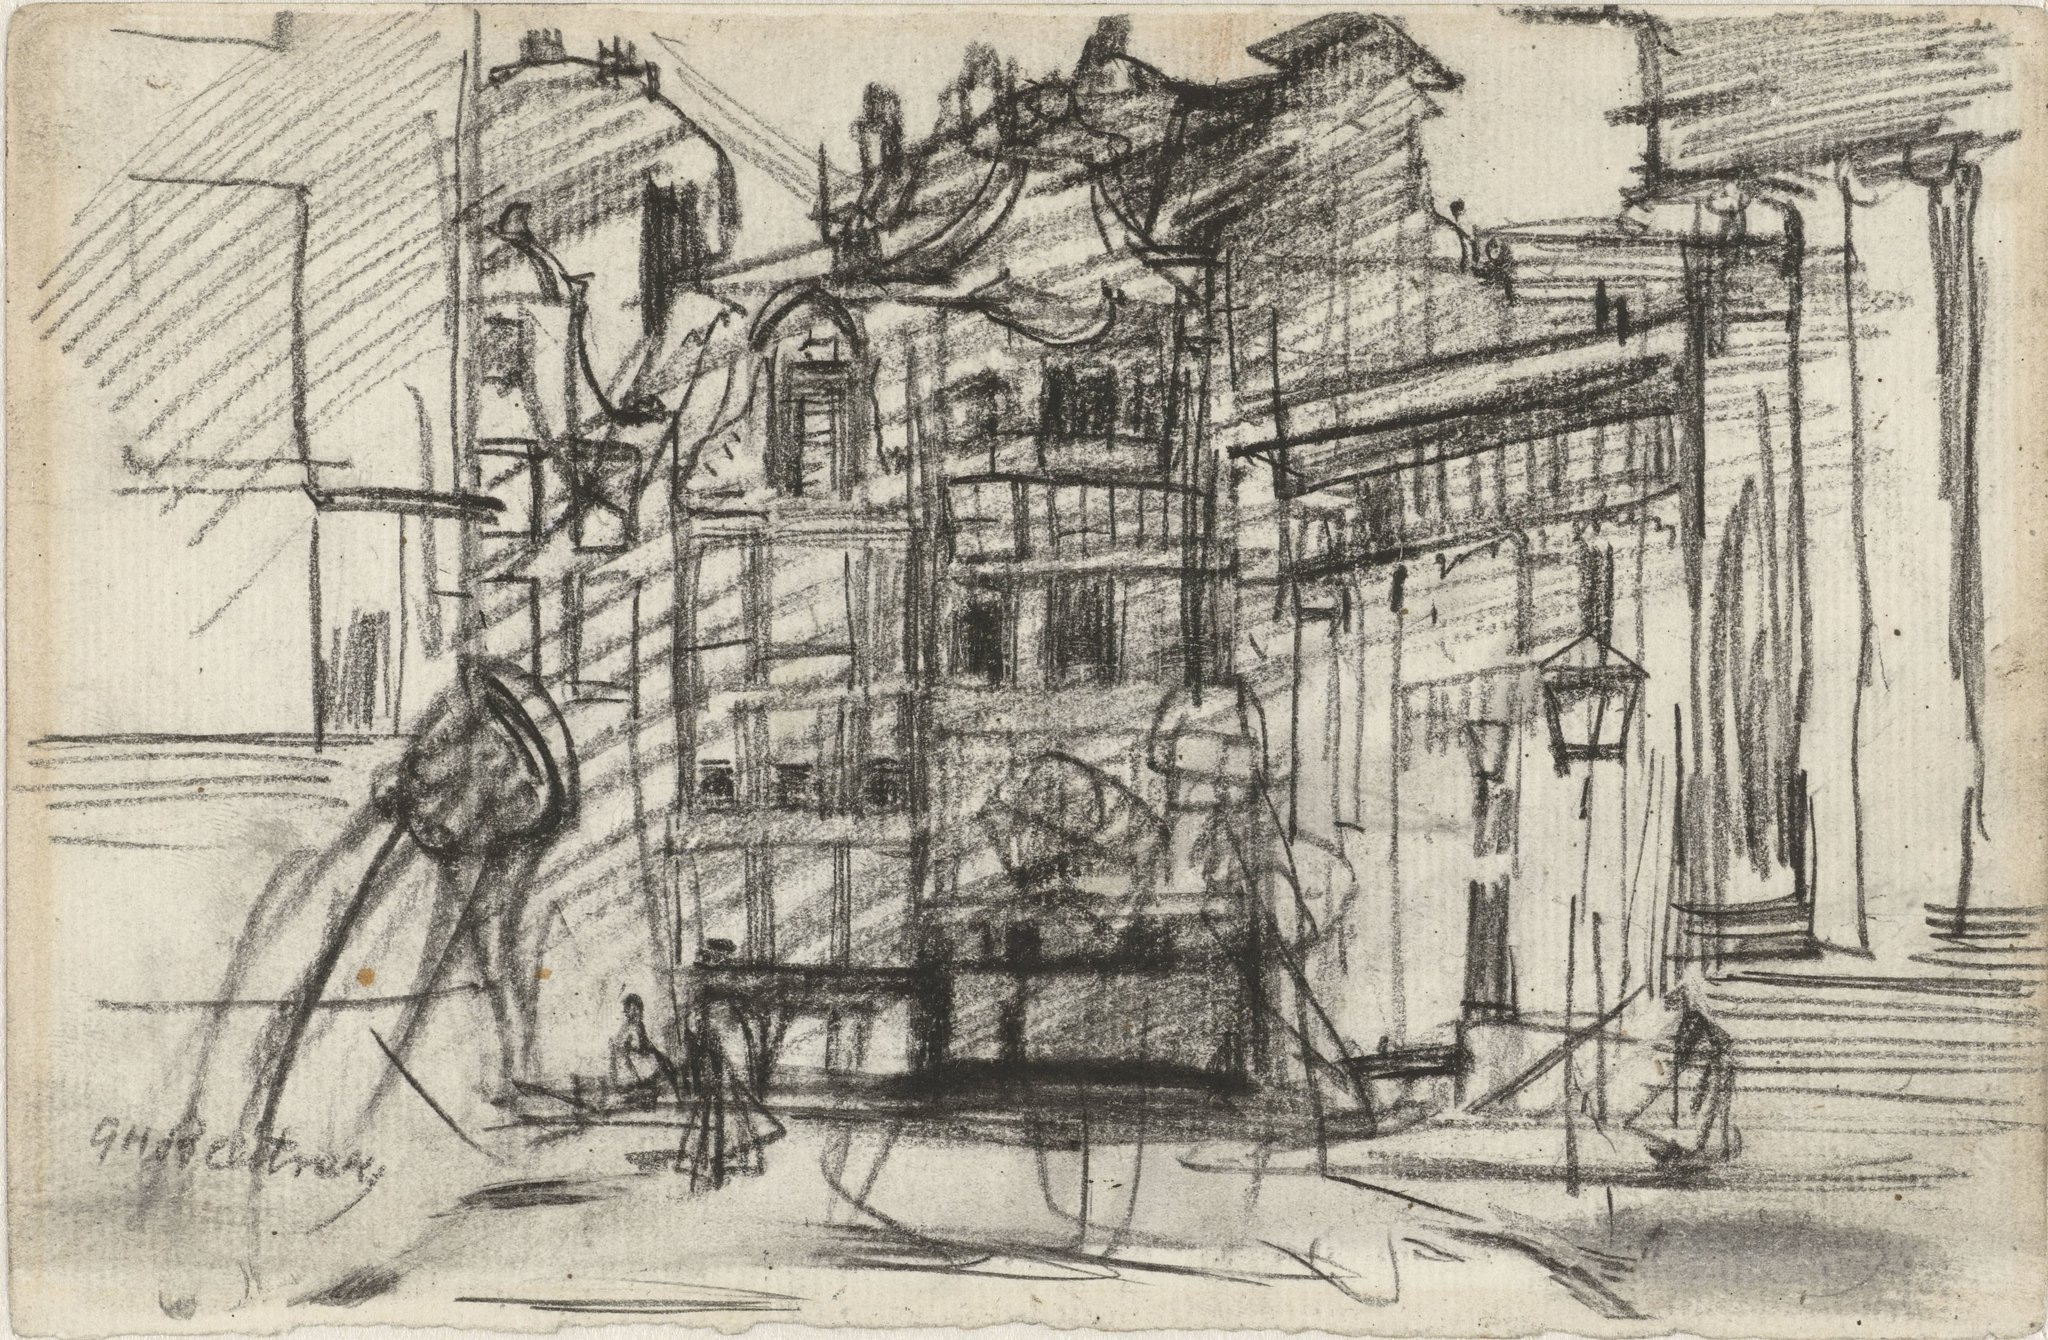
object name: drawing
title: Bouwwerkzaamheden bij de oude beurs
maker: george hendrik breitner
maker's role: draughtsman, painter, print maker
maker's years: 1857-1923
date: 1867-1923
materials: chalk, paper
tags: stock exchange, stock-market, amsterdam